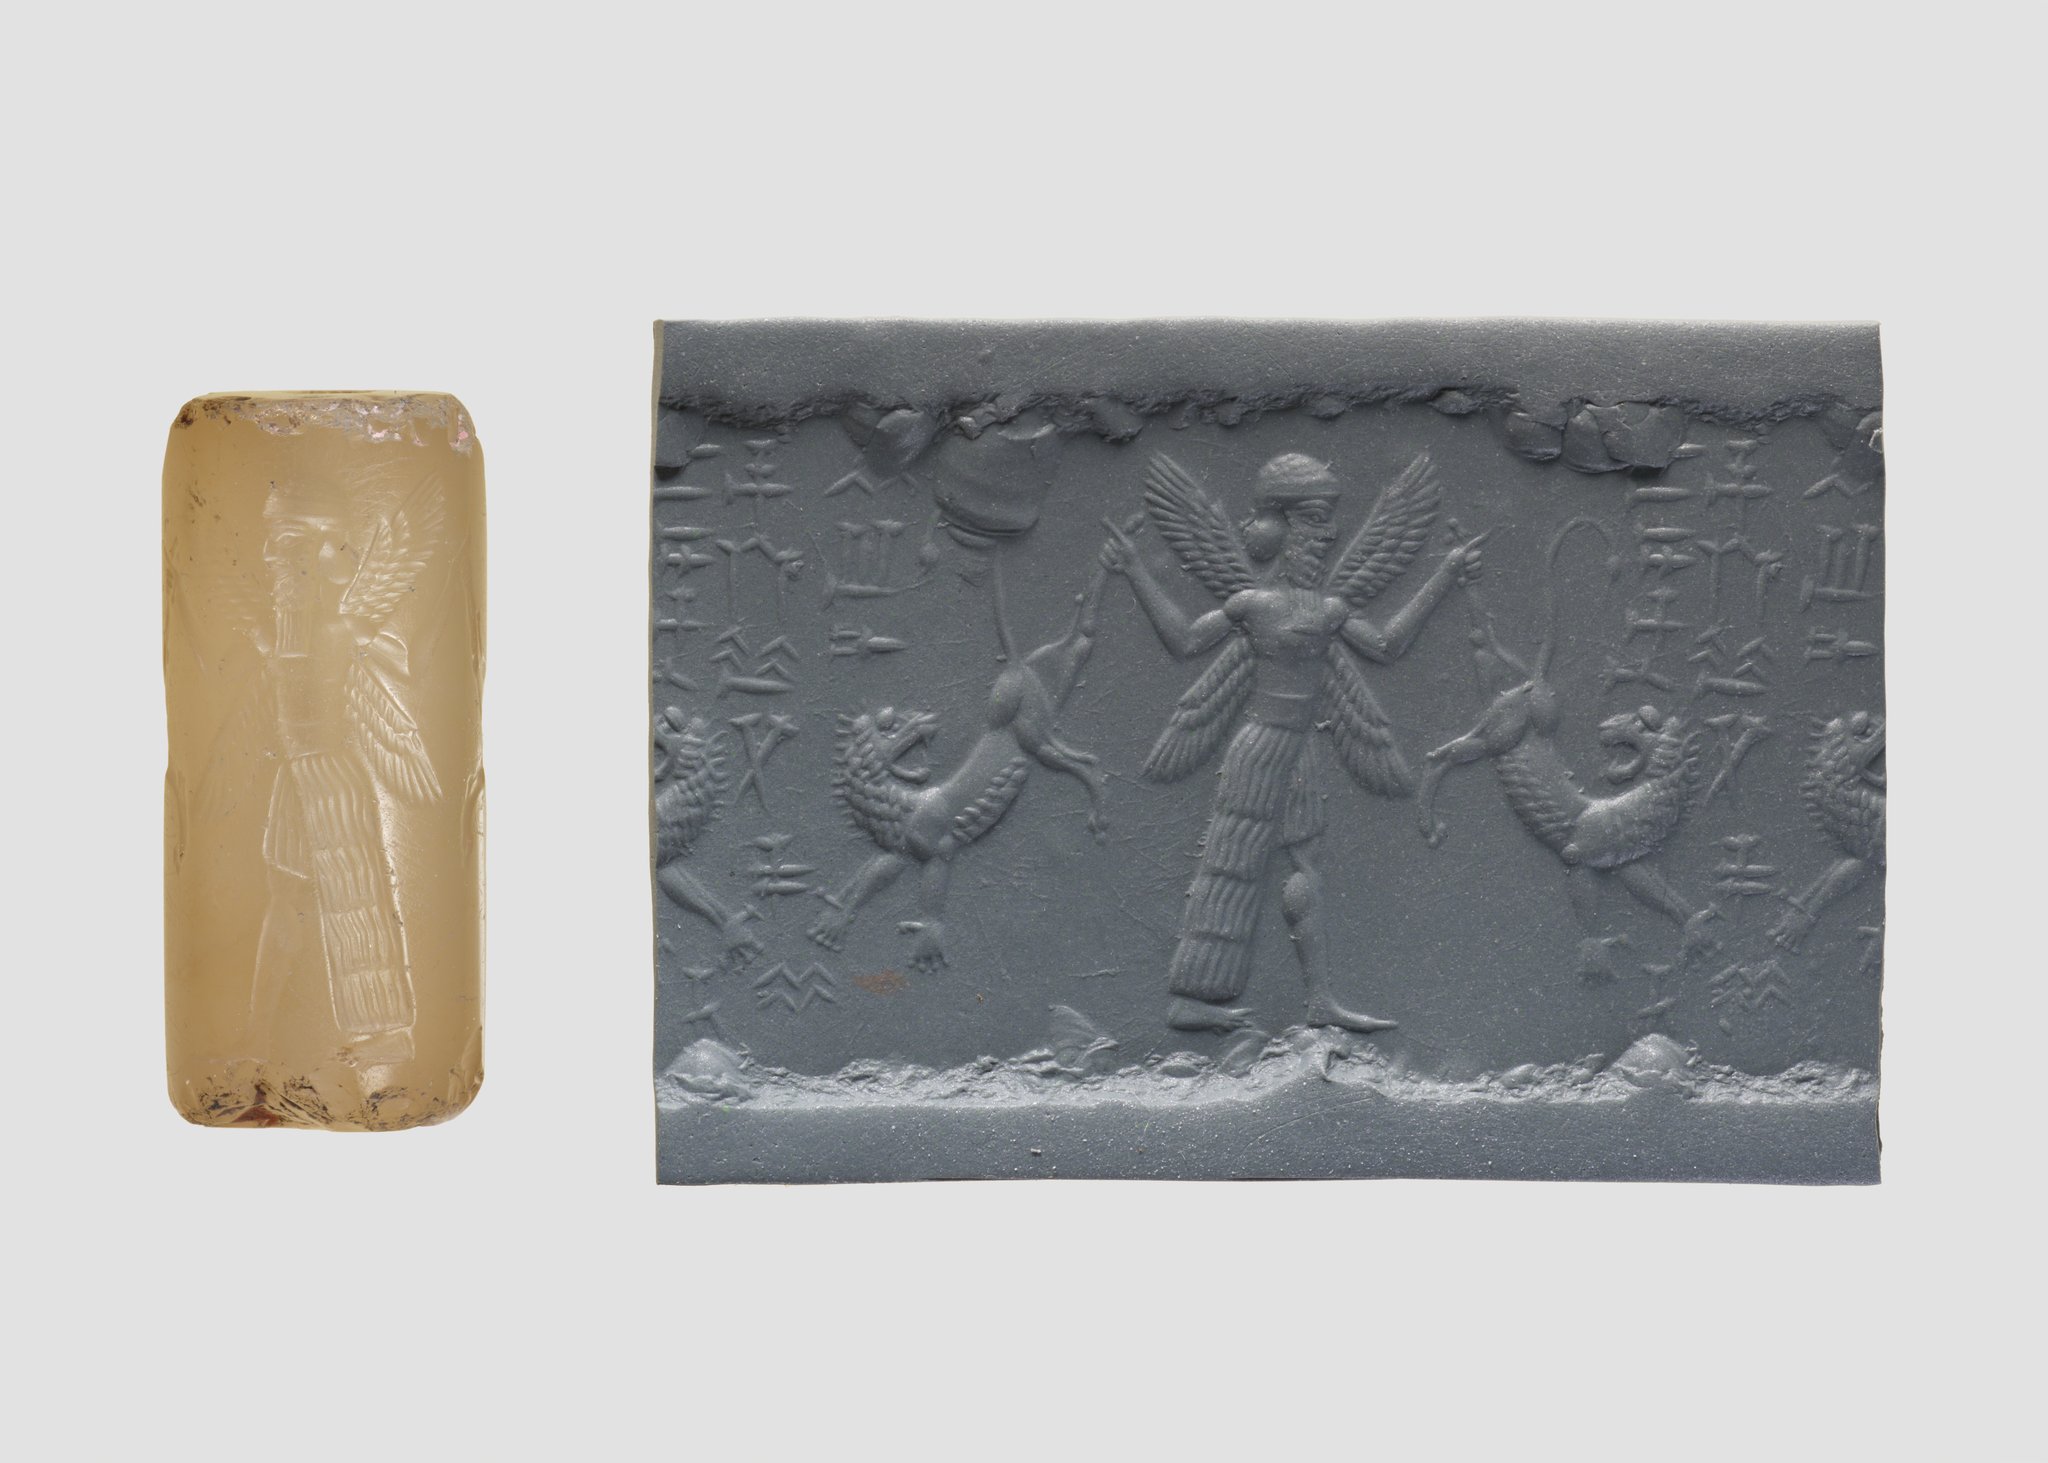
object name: cylinder seal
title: Cylinder seal with three-figure contest scene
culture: babylonian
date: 734-601 BCE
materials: stone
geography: mesopotamia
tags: lions